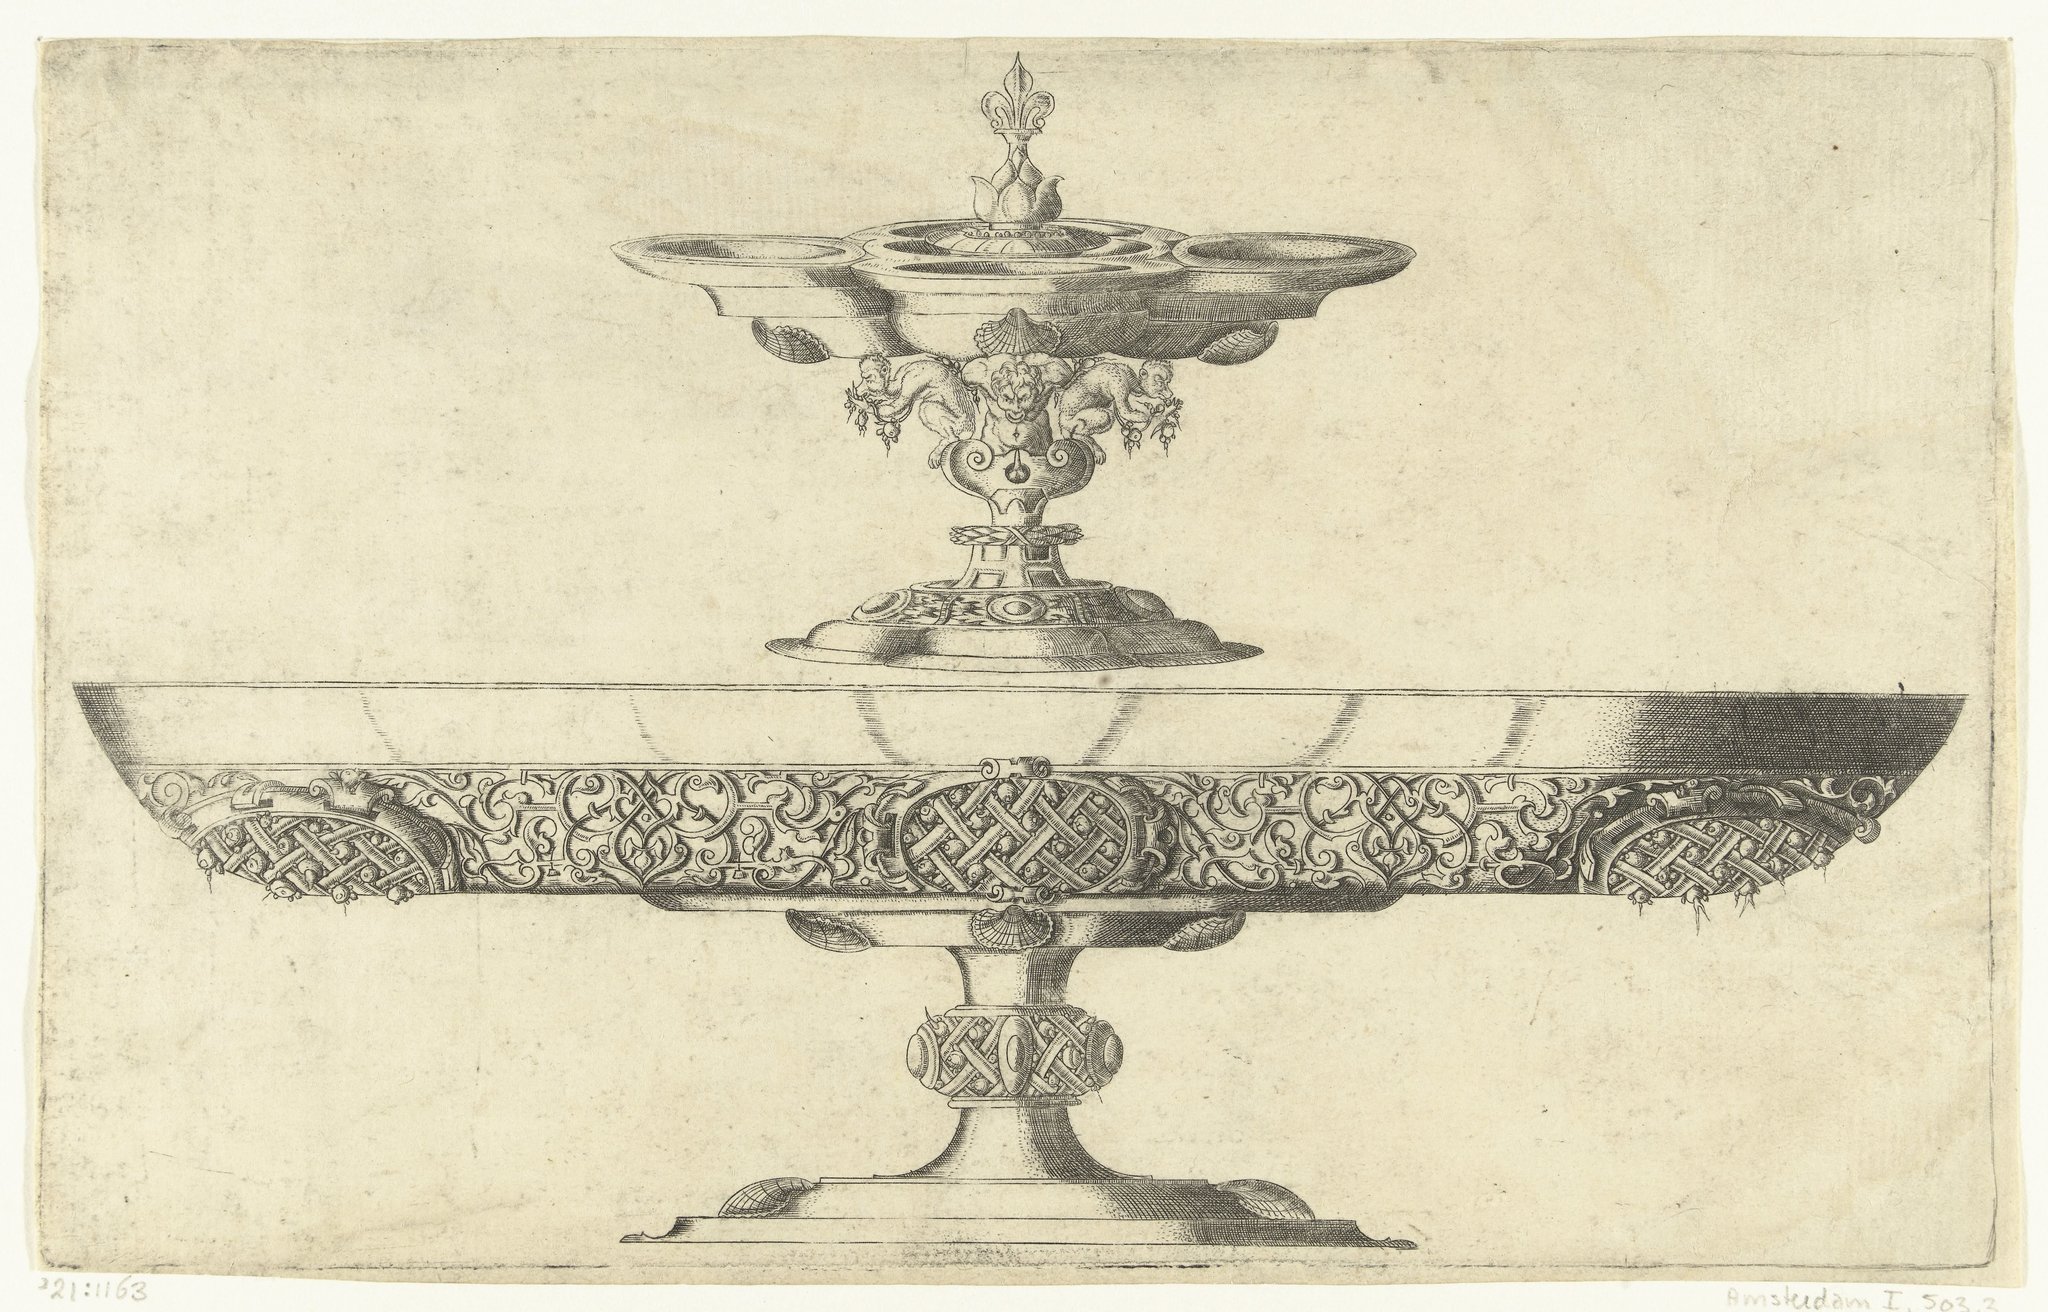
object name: print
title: Schaal en daarboven een zoutvat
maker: Anonymous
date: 1508-1551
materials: paper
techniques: engraving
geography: germany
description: Het zoutvat is gedecoreerd met groteske wezens. Uit een serie, bestaande uit een titelblad en 30 bladen met vaatwerk.